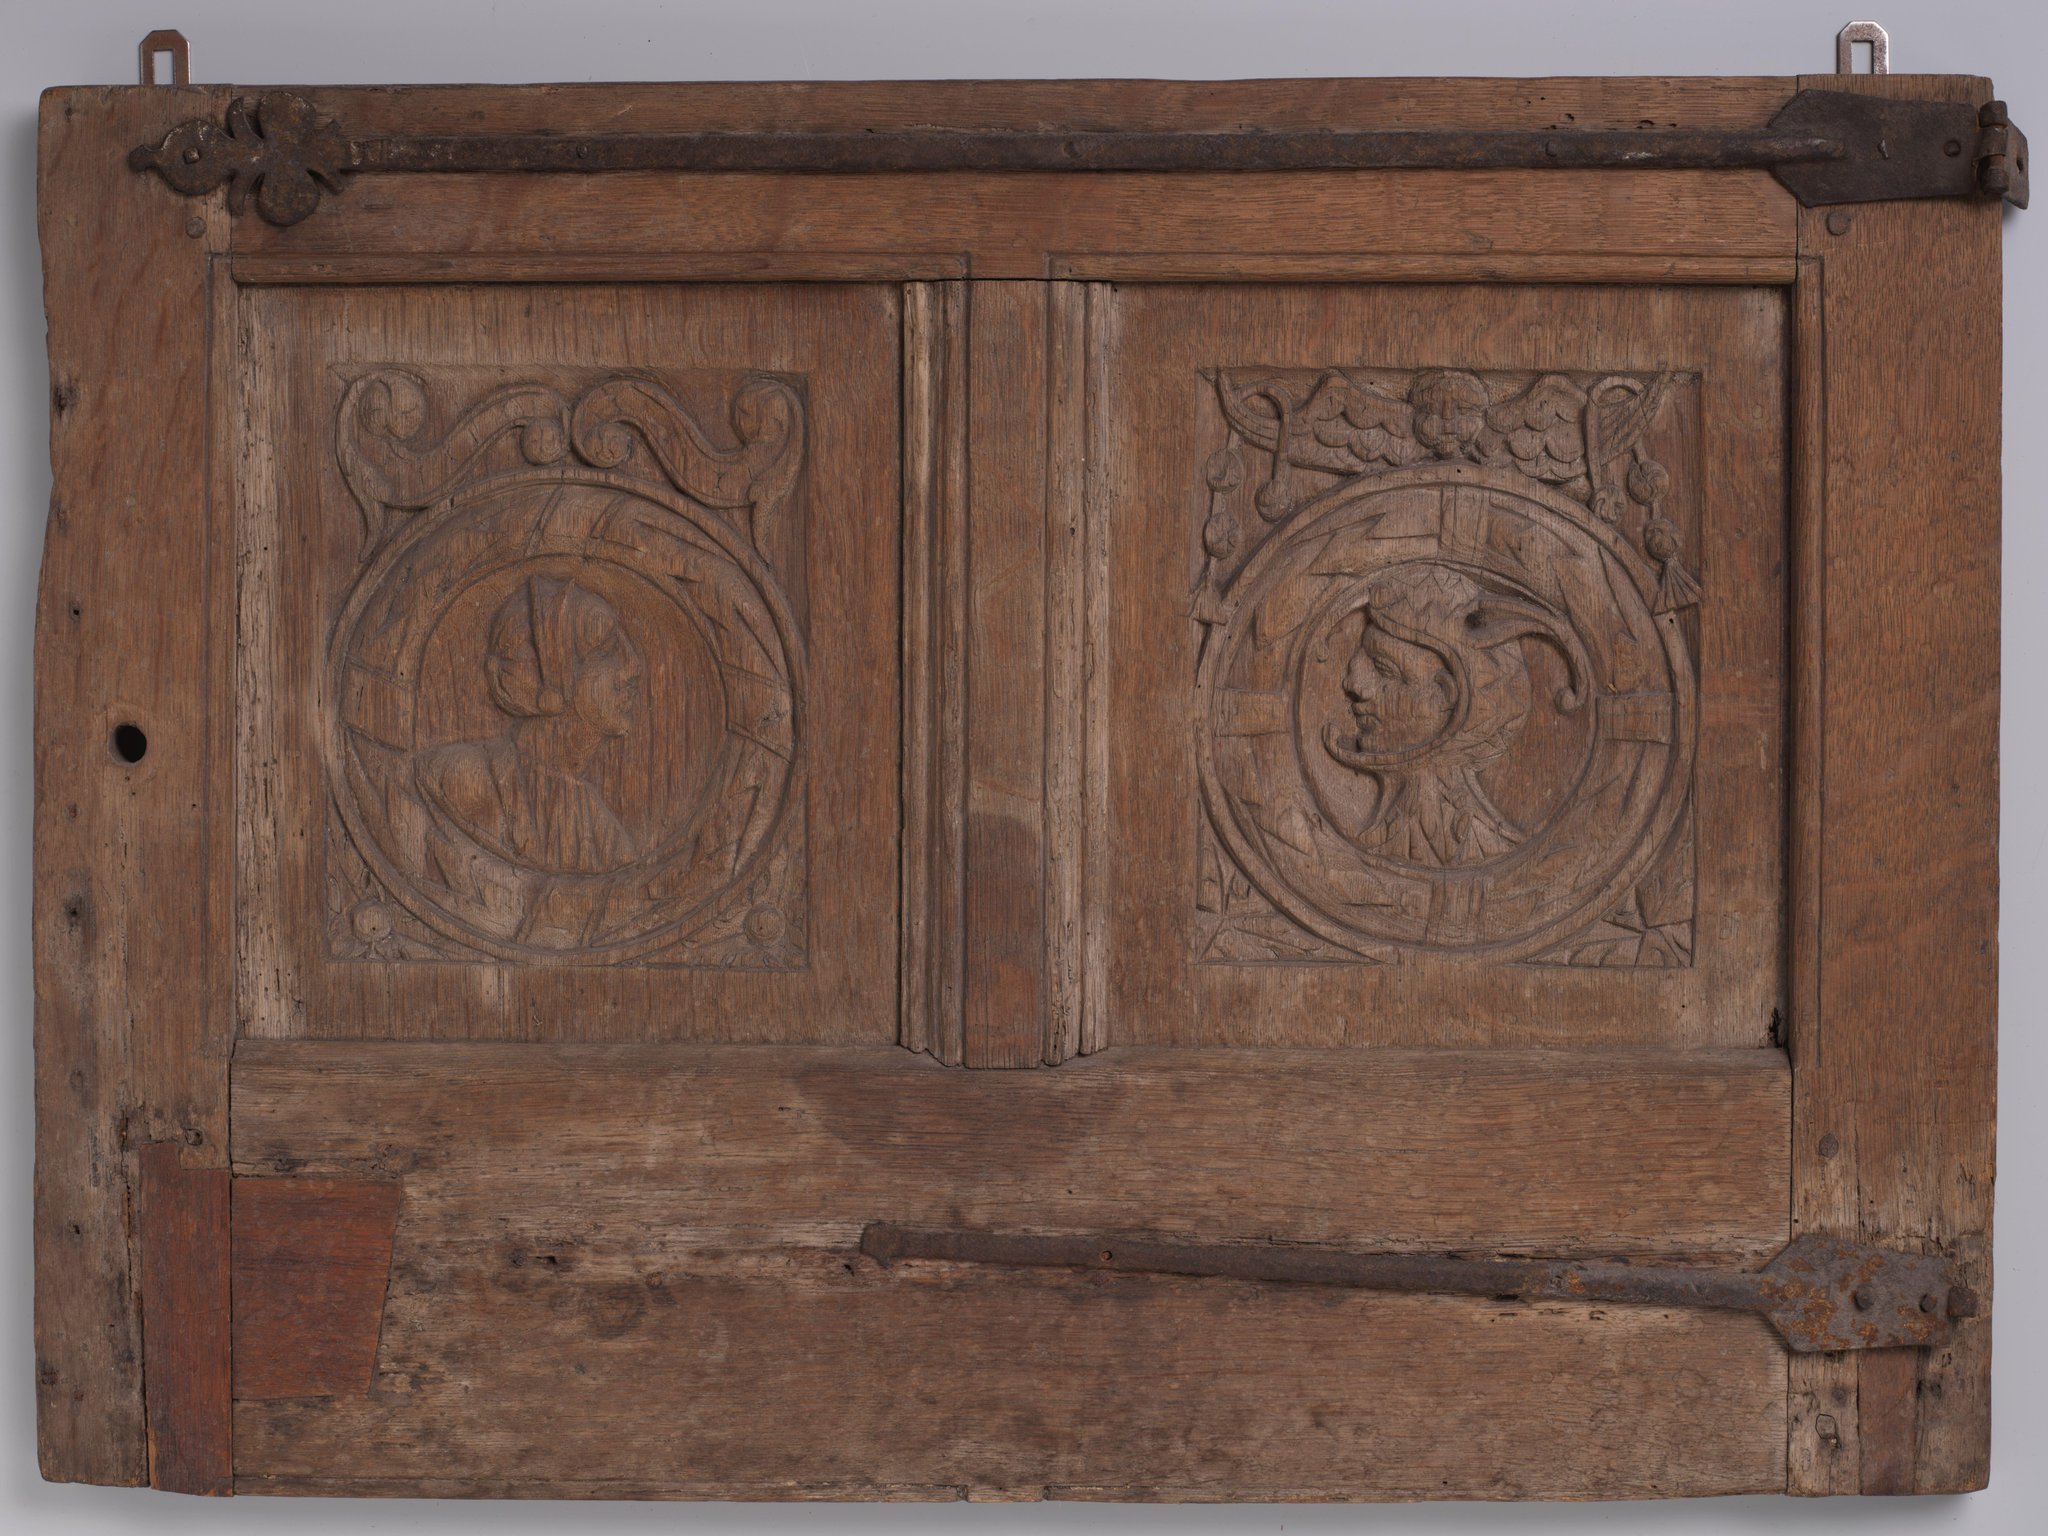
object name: panel surface component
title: Paneel of kastdeur met gesneden koppen en profil in medaillons.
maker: Anonymous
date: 1500-1600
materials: iron, wood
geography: netherlands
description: Eikenhouten paneel of kastdeur met ijzeren beslag, versierd met twee gebeeldhouwde medaillons met koppen in profiel. Zie tevens: BK-NM-10914-a.